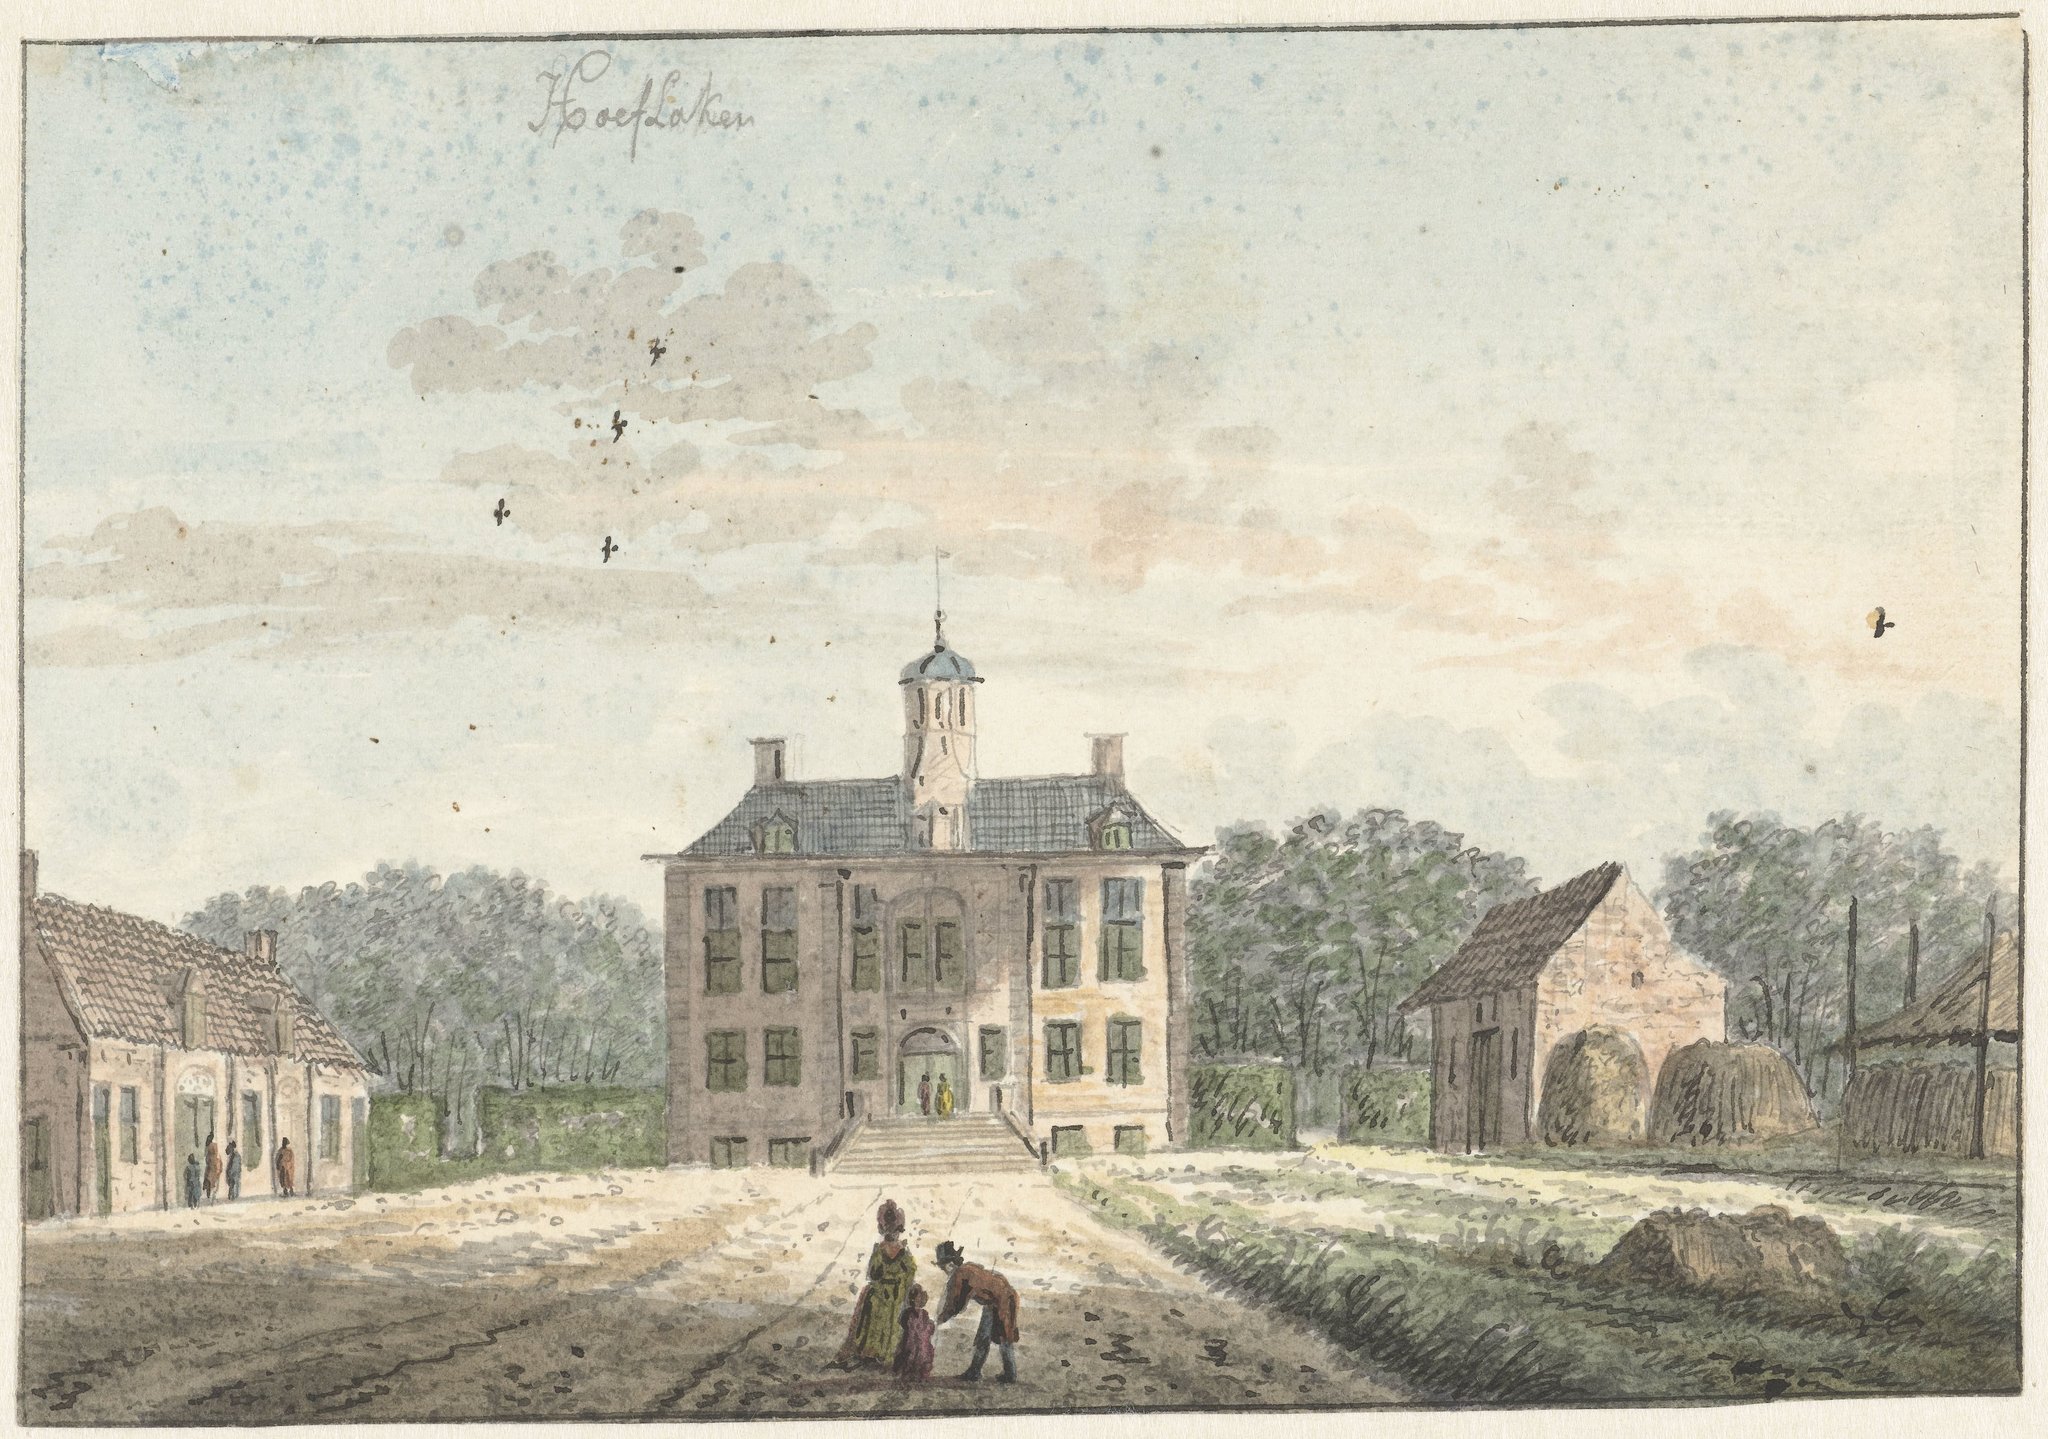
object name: drawing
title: Huis te Hoevelaken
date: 1701-1759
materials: ink, paper, pencil, watercolor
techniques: brush, pen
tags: castle